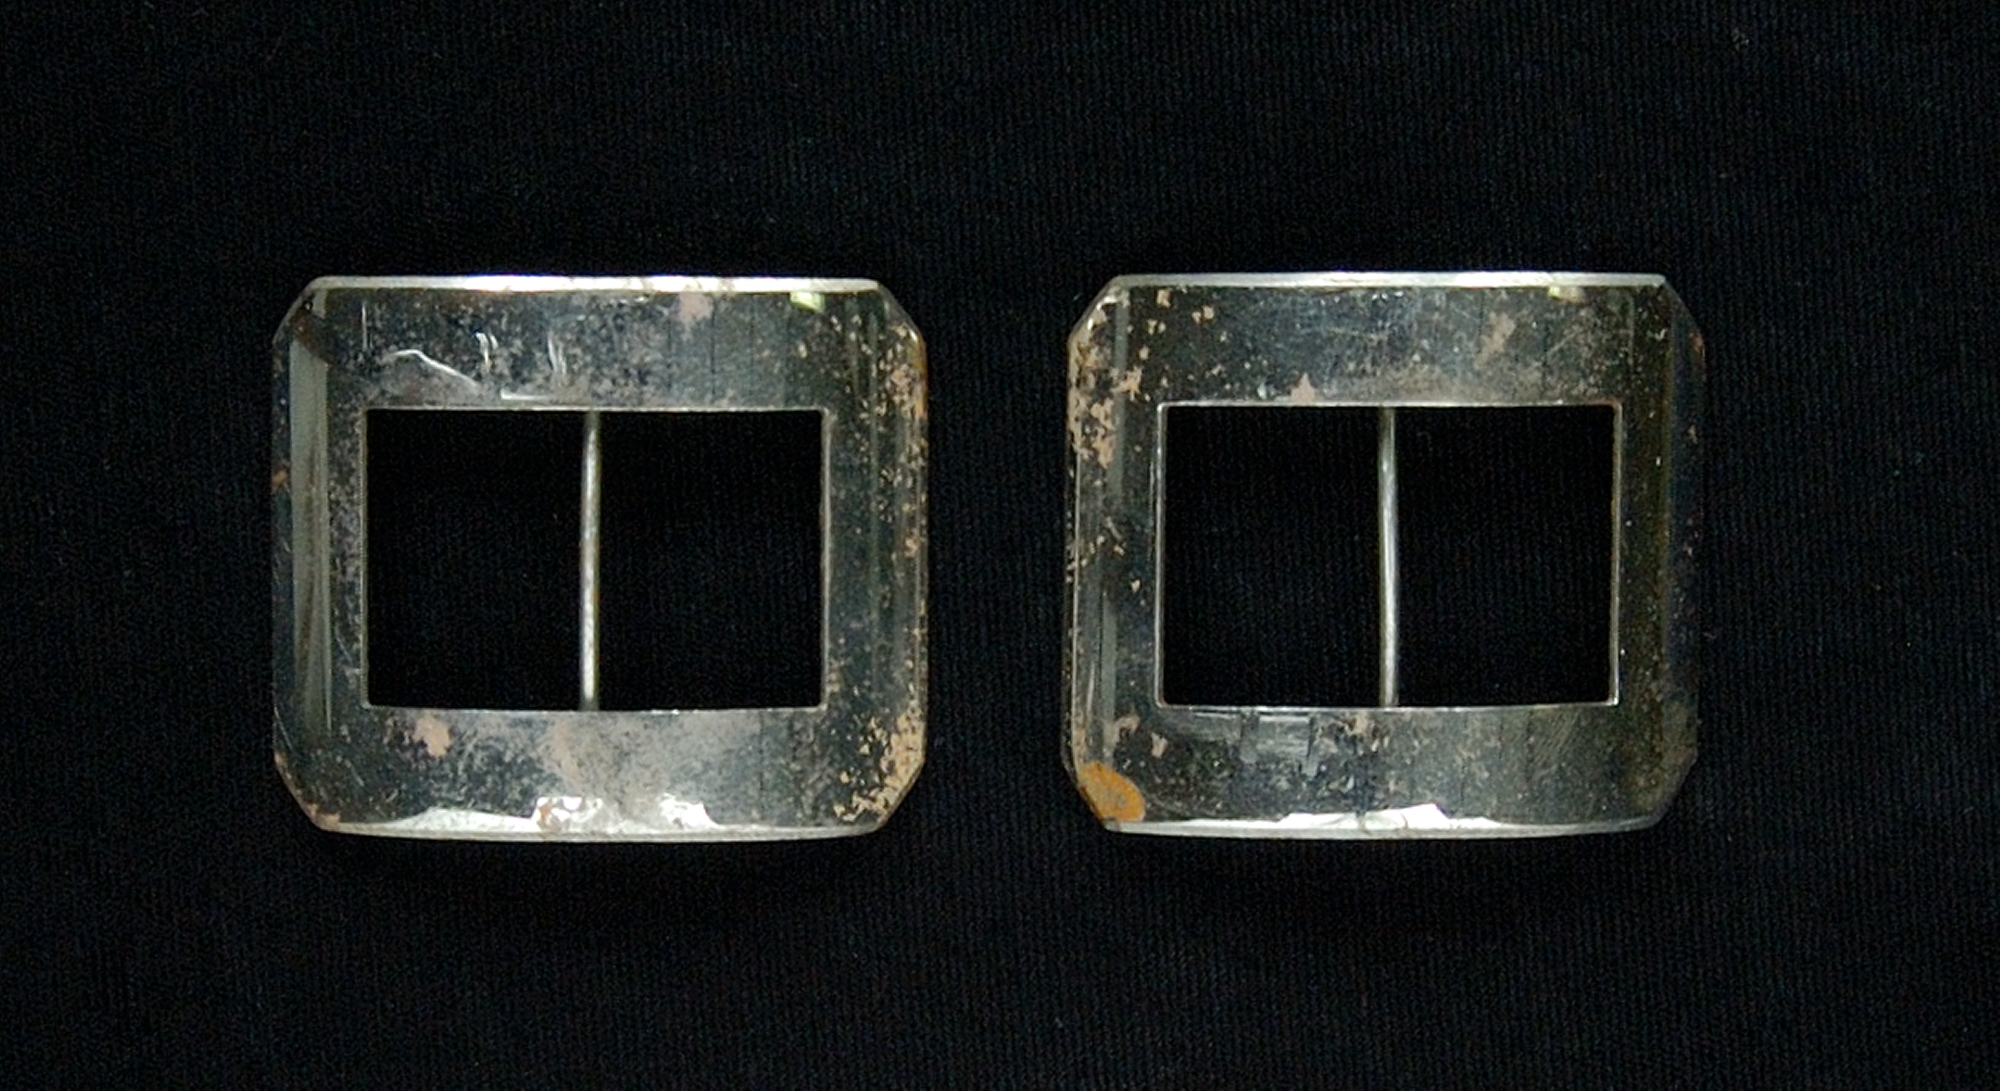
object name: shoe buckle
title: Shoe buckles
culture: american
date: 1876-1900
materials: metal